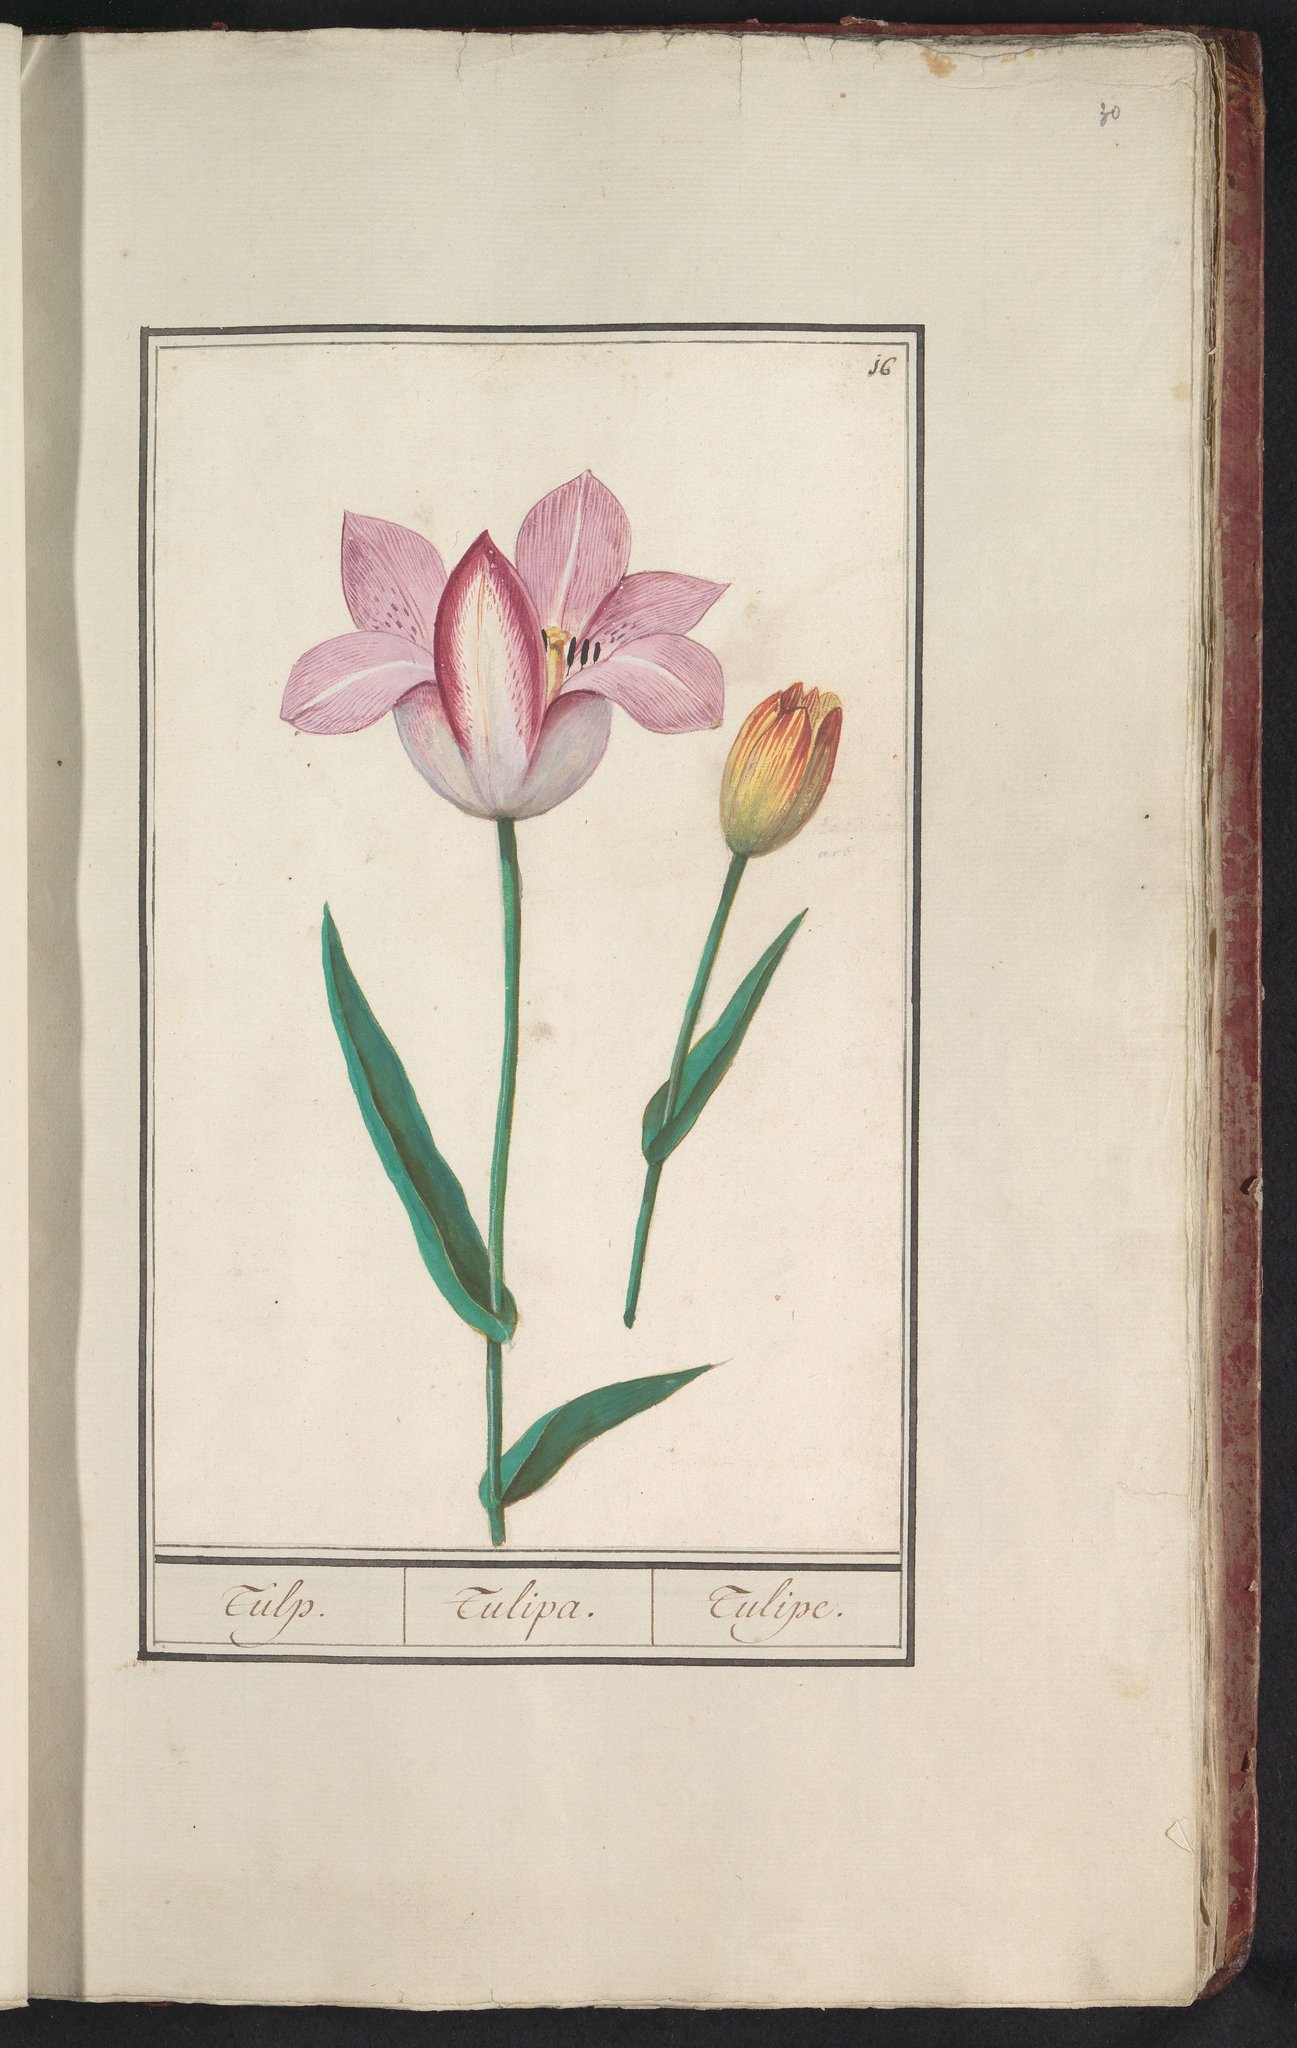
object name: drawing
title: Tulp. / Tulipa. / Tulipe.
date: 1596-1610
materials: chalk, paint, paper, watercolor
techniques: brush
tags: flowers: tulip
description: Roze tulp en een geelrode tulp. Genummerd rechtsboven: 16. Onderdeel van het eerste album met tekeningen van bloemen en planten. Achtste van twaalf albums met tekeningen van dieren, vogels en planten bekend rond 1600, gemaakt in opdracht van keizer Rudolf II. Met toelichting in Nederlands, Latijn en Frans.